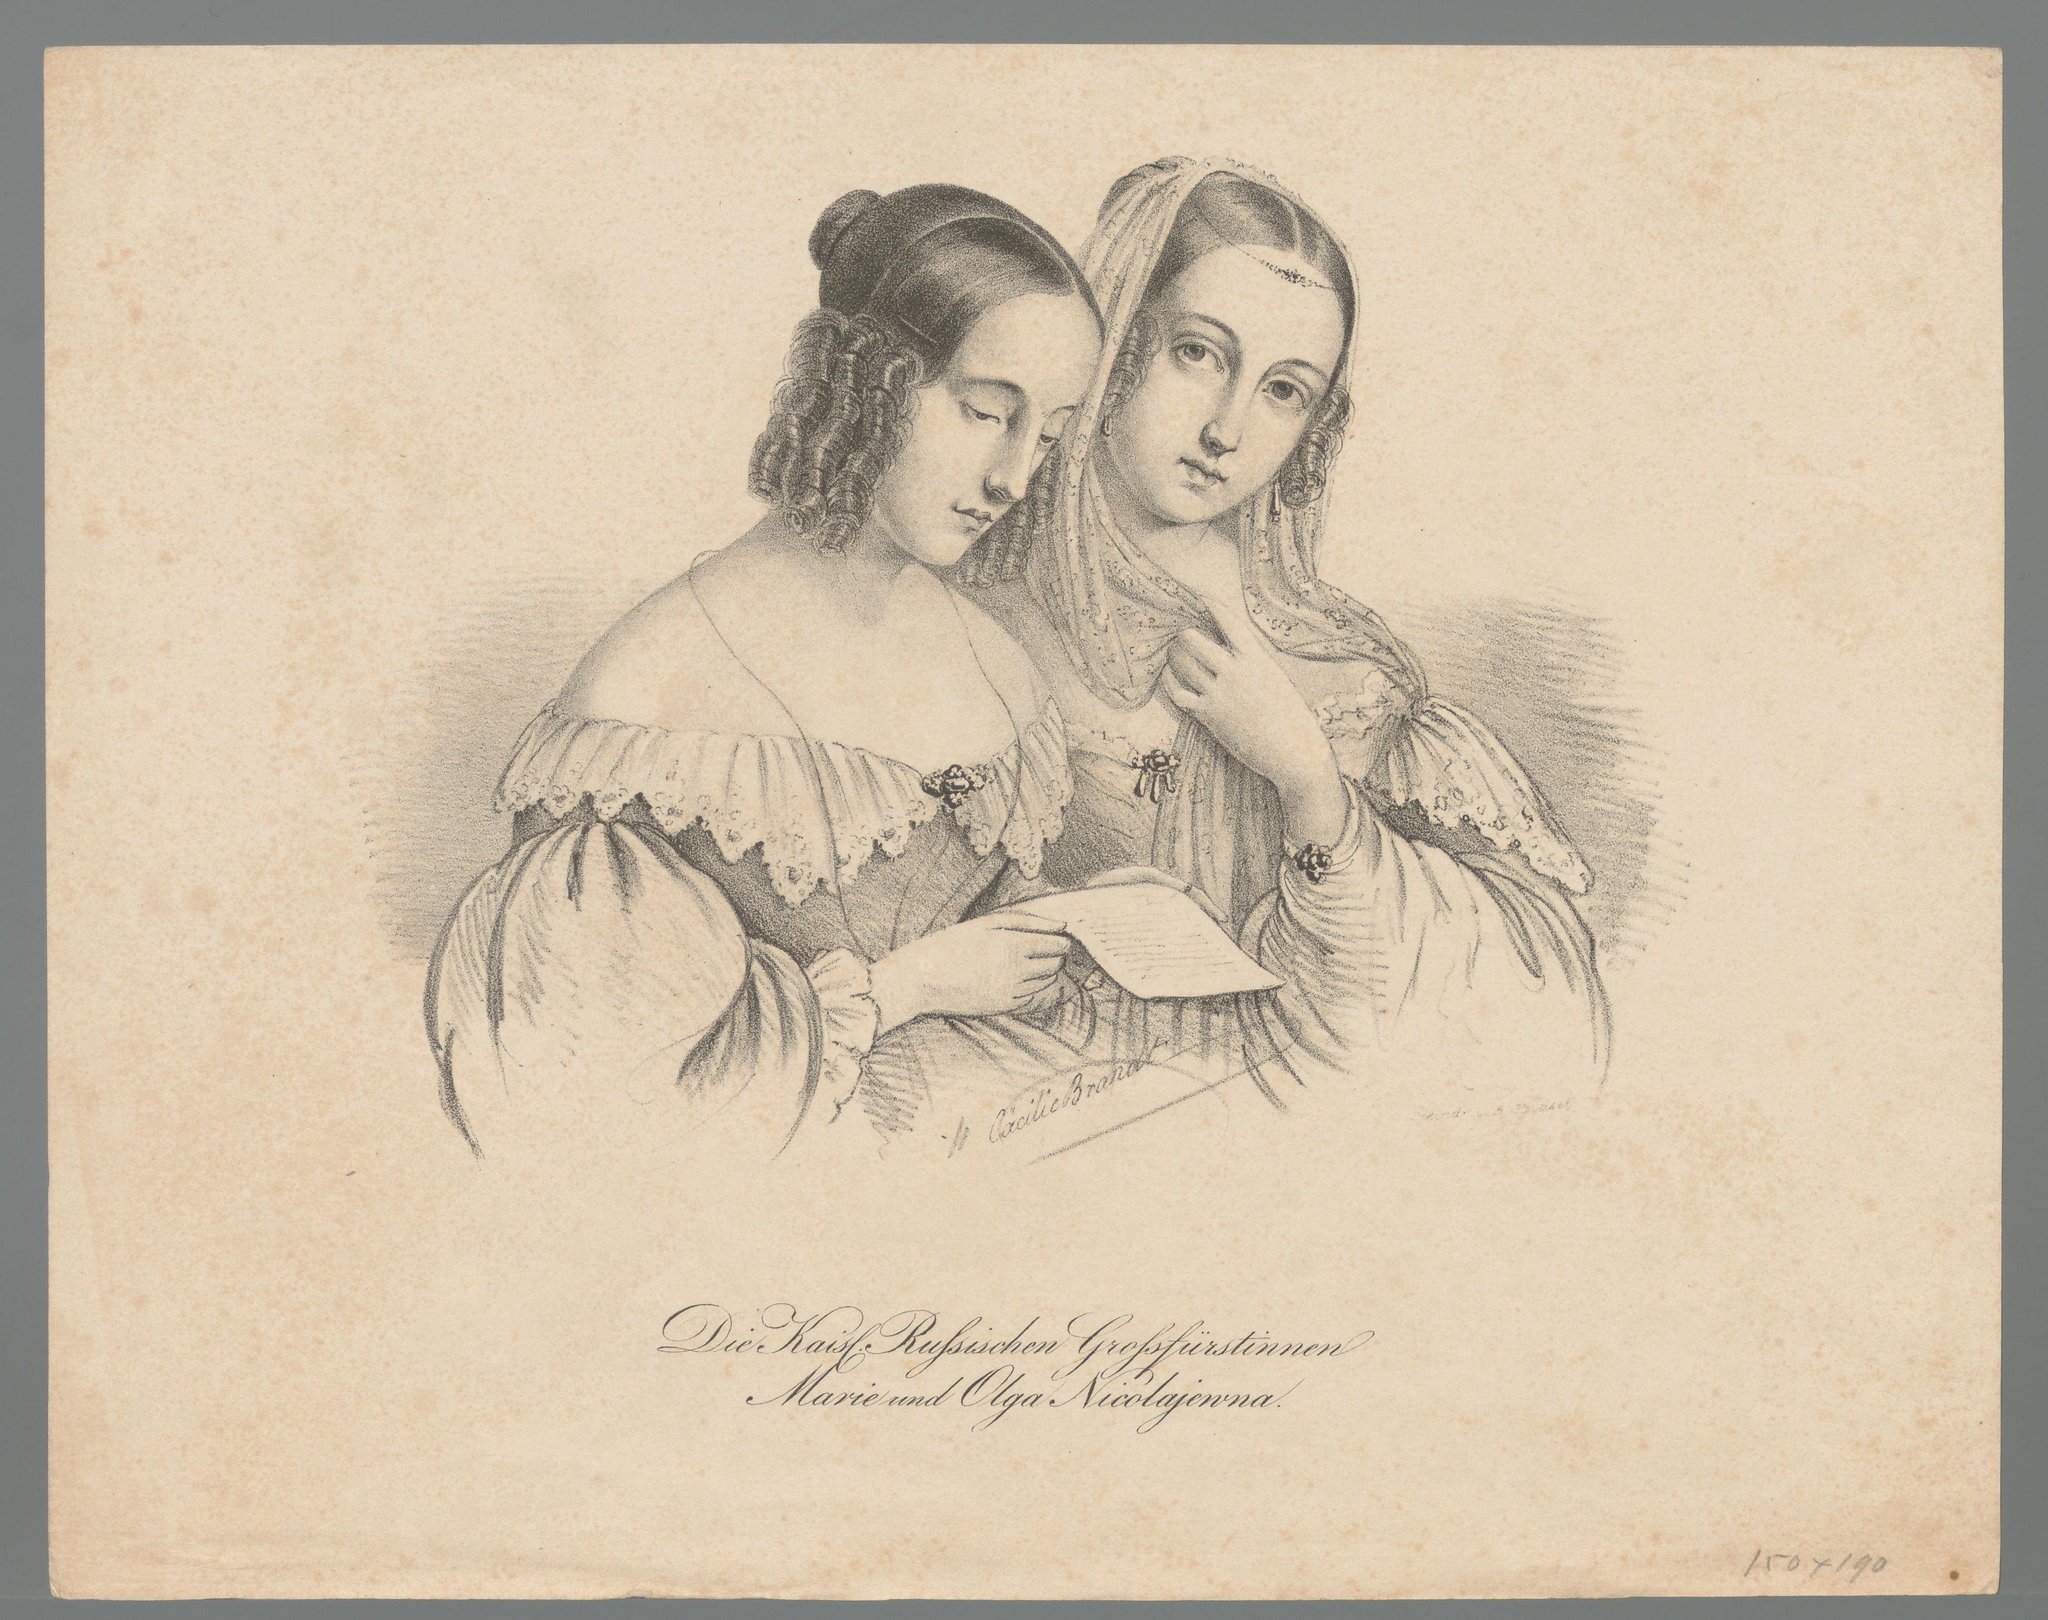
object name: print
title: Portret van Maria en Olga Nikolajevna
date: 1825-1850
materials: paper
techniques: lithograph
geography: leipzig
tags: historical persons, adult woman (+ two persons)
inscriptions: collector's mark: Lugt 2228